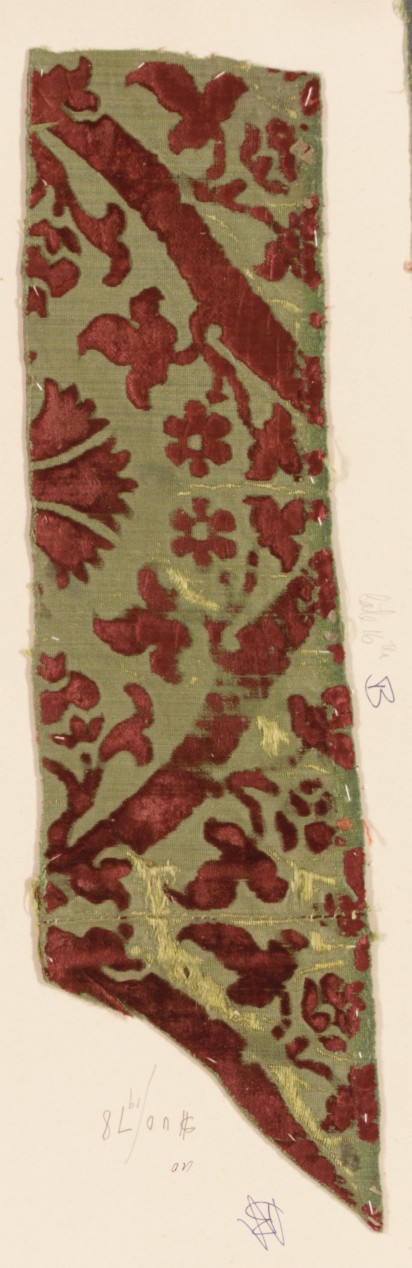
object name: fragment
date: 1567-1600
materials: silk